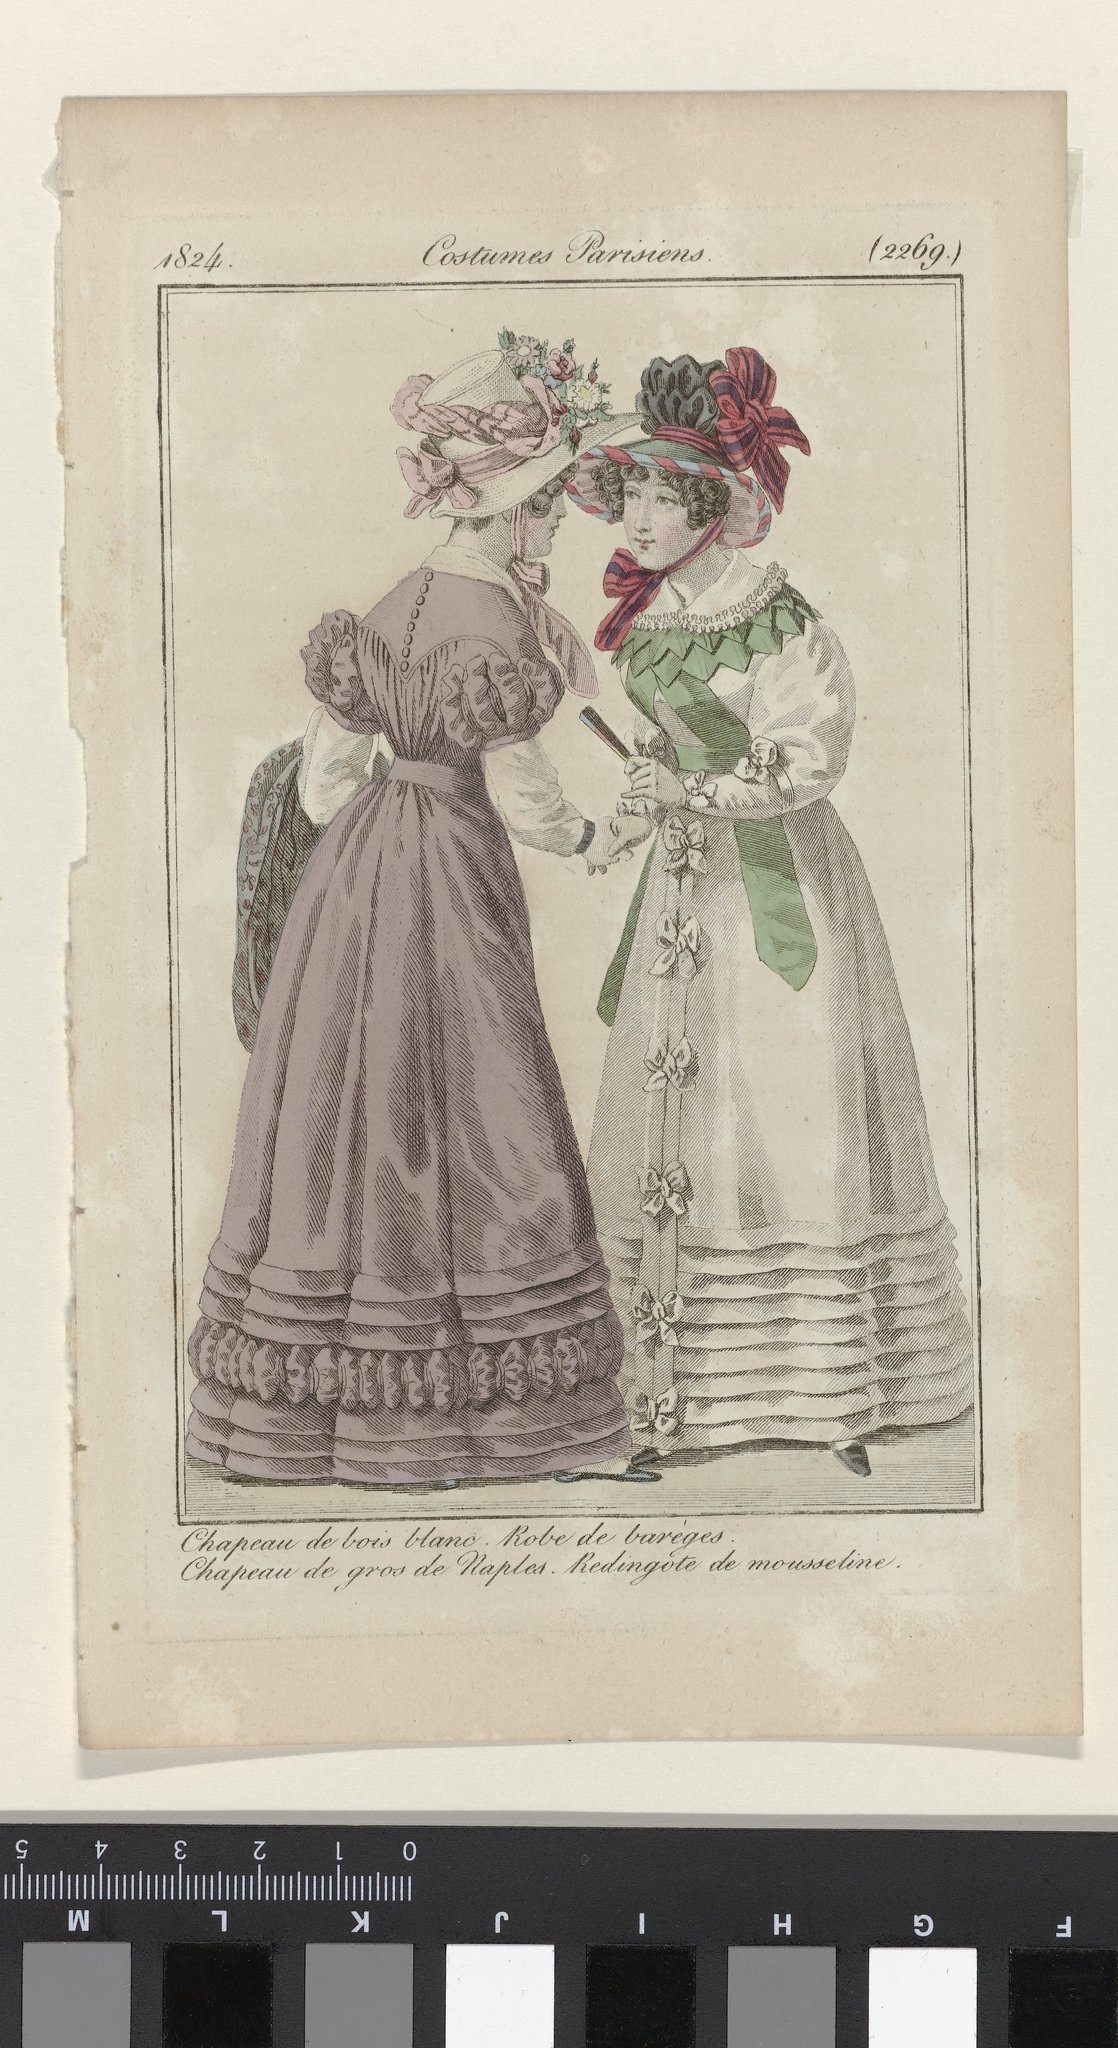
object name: fashion print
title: Journal des Dames et des Modes, Costumes Parisiens, 10 octobre 1824, (2269): Chapeau de bois blanc (...)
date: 1824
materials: paper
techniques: engraving, hand coloring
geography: paris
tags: bow (ornamental part of clothing) (+ women's clothes), clothing for the upper part of the body (shawl) (+ women's clothes), shaking hands, 'dextrarum junctio', dress, gown: redingote (+ women's clothes), fashion plates, head-gear: hat (+ women's clothes), shoes, sandals (+ women's clothes), gloves, mittens, etc. (+ women's clothes), dress, gown (+ women's clothes), fan (+ women's clothes)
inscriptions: caption: ‘Chapeau de bois blanc. Robe de barèges. Chapeau de gros de Naples. Redingote de mousseline.’, title: ‘Costumes Parisiens.’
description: Twee vrouwen van wie de linker op de rug gezien. Zij draagt een japon van barège. Op het hoofd een hoed van 'bois blanc'. De vrouw rechts draagt een redingote van mousseline, met strikken op de mouwen en rok. Hoed van 'gros de Naples'. De prent maakt deel uit van het modetijdschrift Journal des Dames et des Modes, uitgegeven door Pierre de la Mésangère, Parijs, 1797-1839.